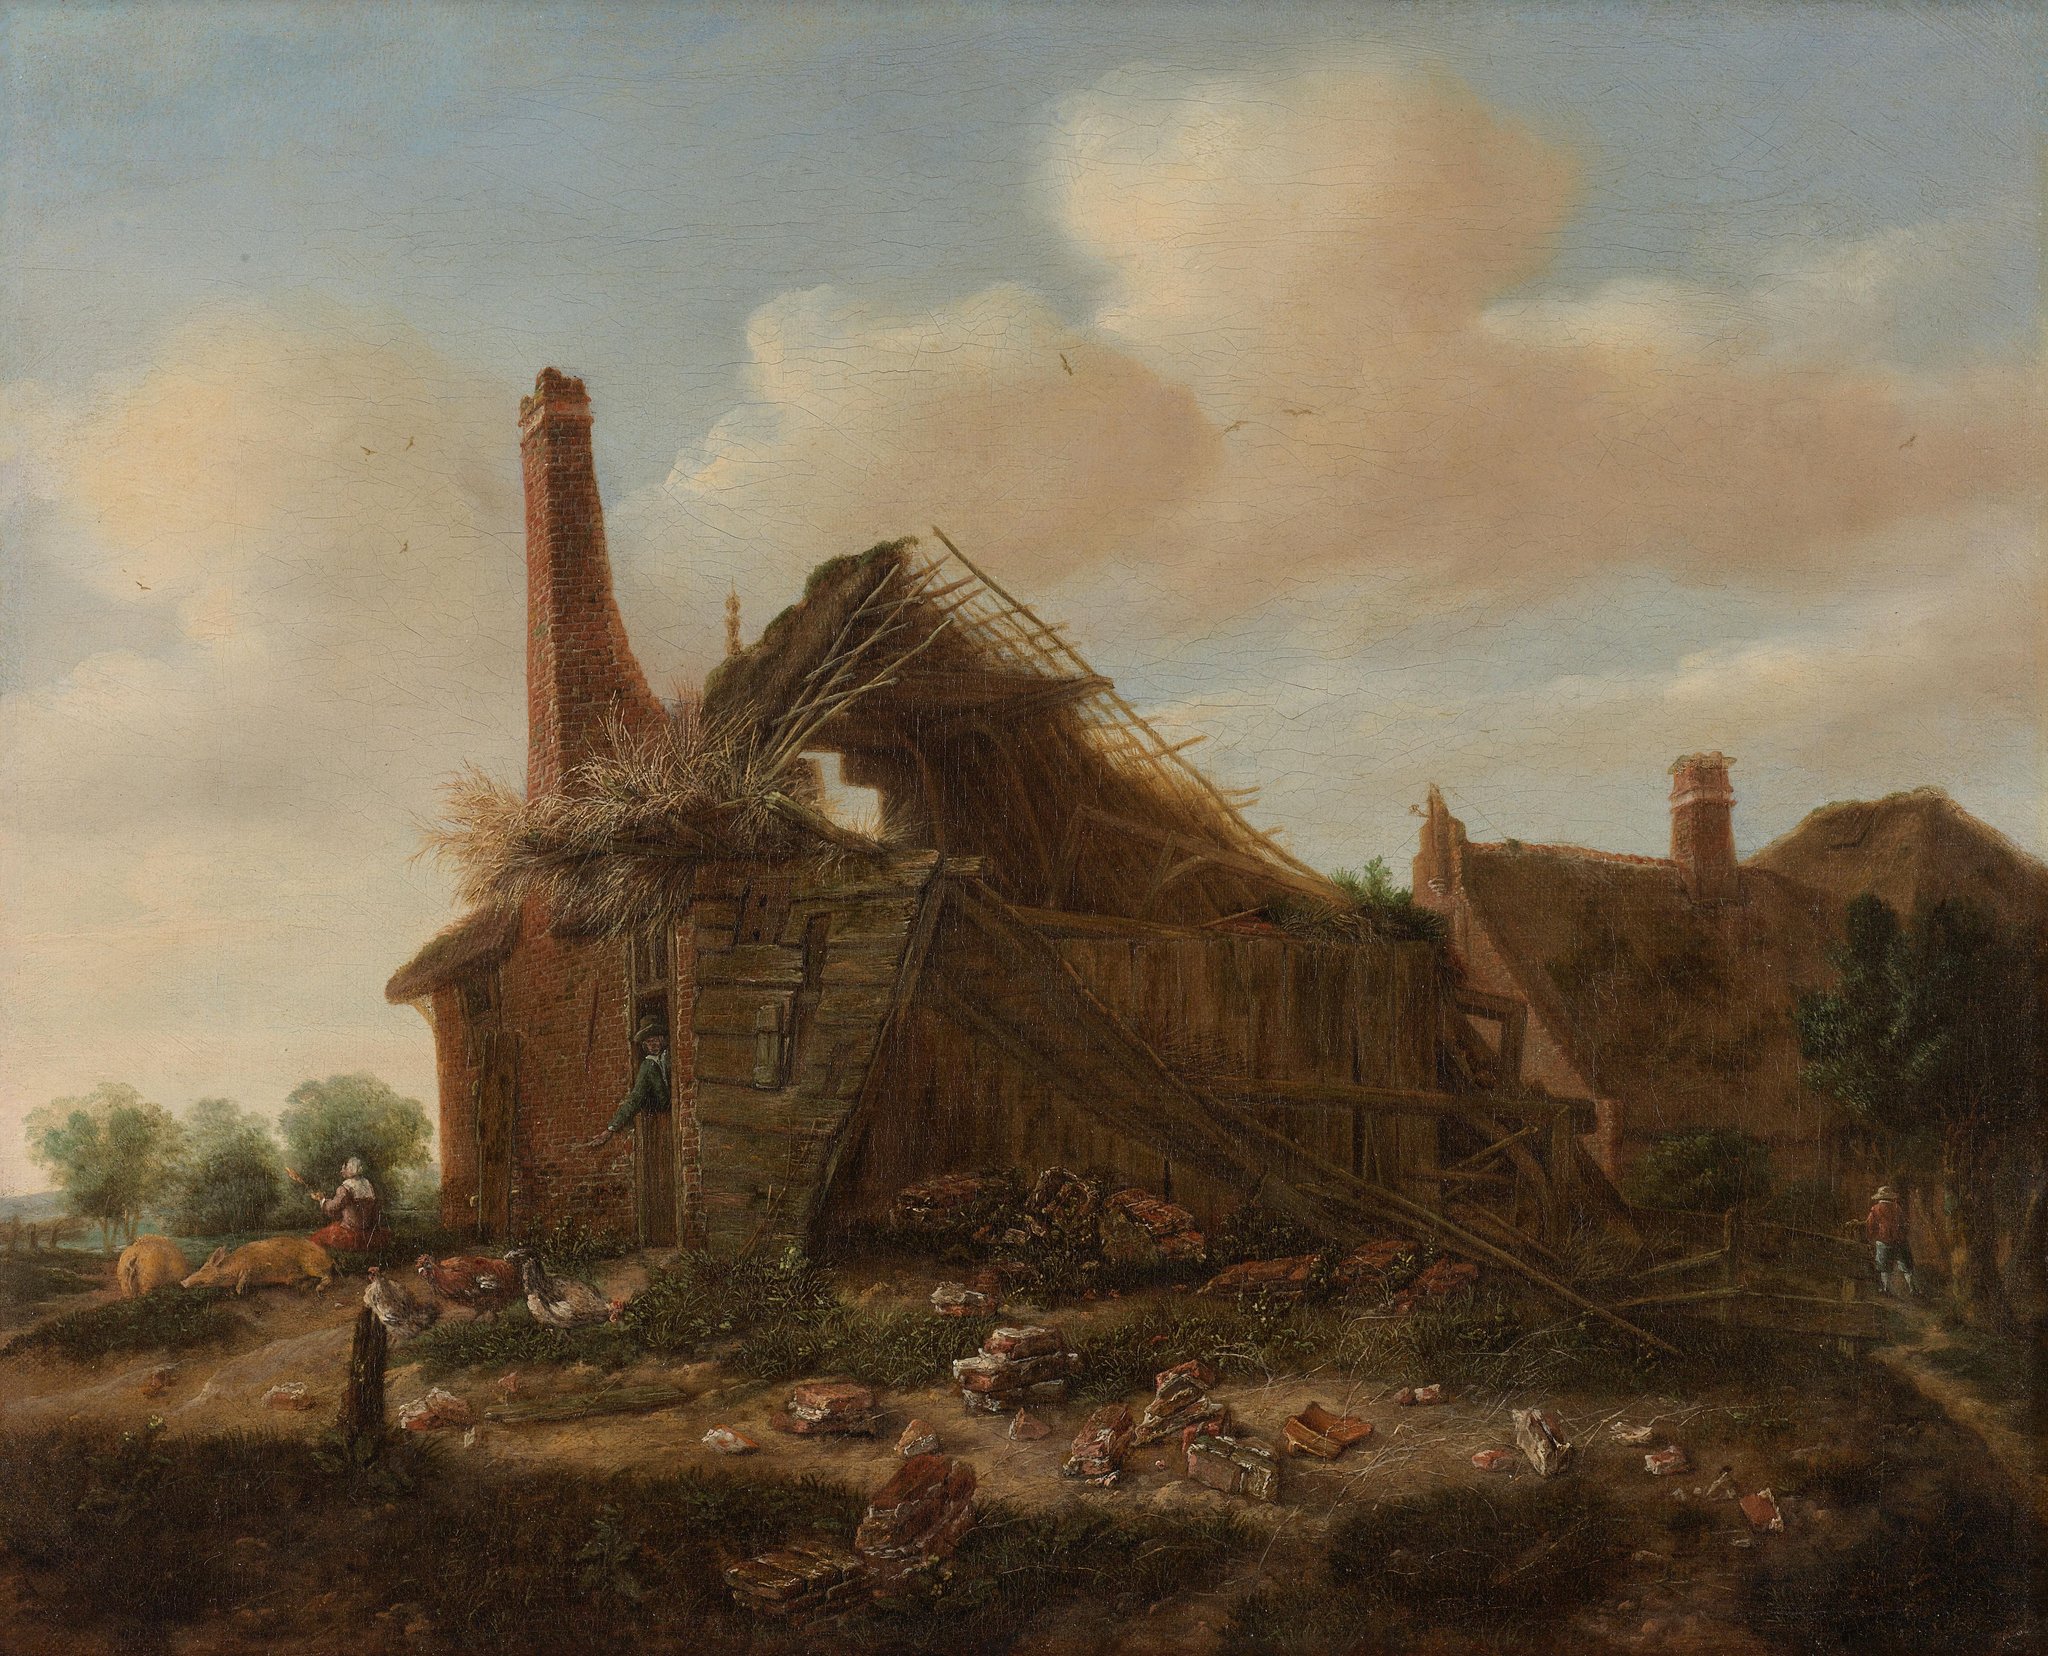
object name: painting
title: Farmhouse in ruins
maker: emanuel murant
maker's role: draughtsman, painter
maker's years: 1622-1700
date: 1650-1700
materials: canvas, oil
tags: landscape with ruins, farm (building), ruin of a dwelling, house, castle, etc.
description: Vervallen boerderij met een man die hangend over de onderdeur kippen voert. Links hoedt een jongen varkens, rechts een man bij een boerderij. Op de voorgrond losse liggen bakstenen en stukken muur.